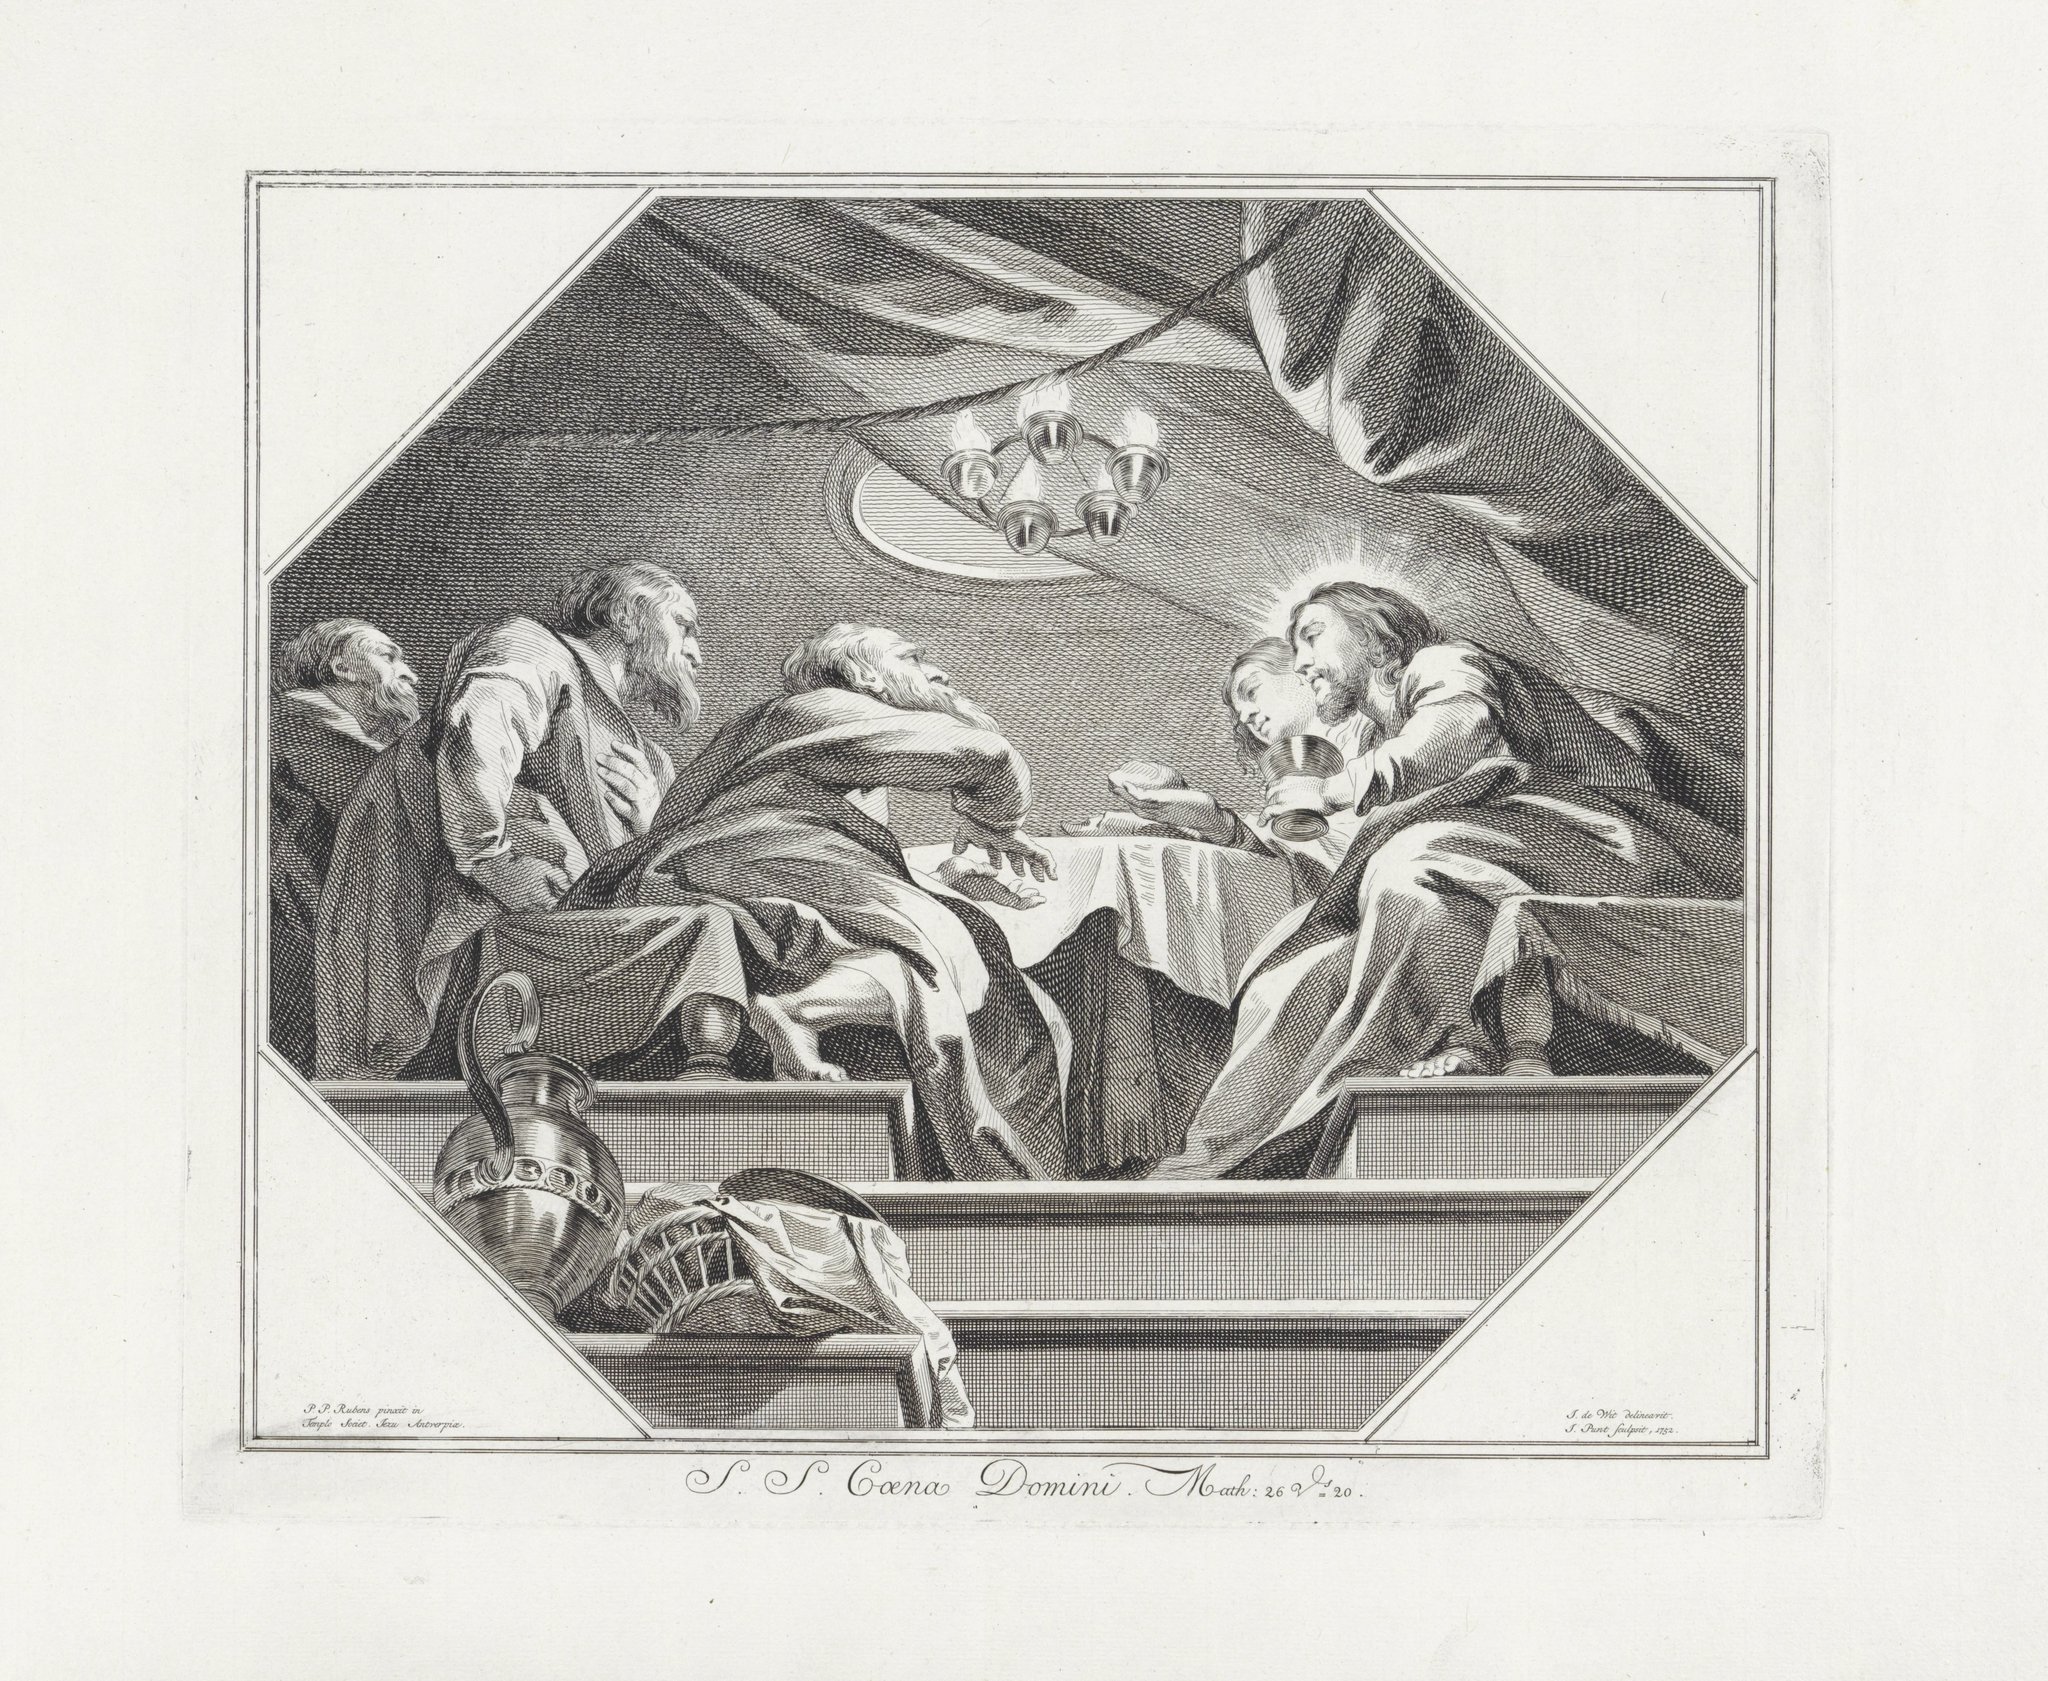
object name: print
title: Laatste Avondmaal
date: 1752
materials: paper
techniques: engraving, etching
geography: amsterdam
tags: last supper (in general) (matthew 26:21-35; mark 14:18-31; luke 22:3, 22:15-23; john 13:21-38)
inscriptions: collector's mark: Lugt 240, date: ‘1752’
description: Laatste Avondmaal; onder de octagonale voorstelling een vers in het Latijn uit Mat. 26:20.